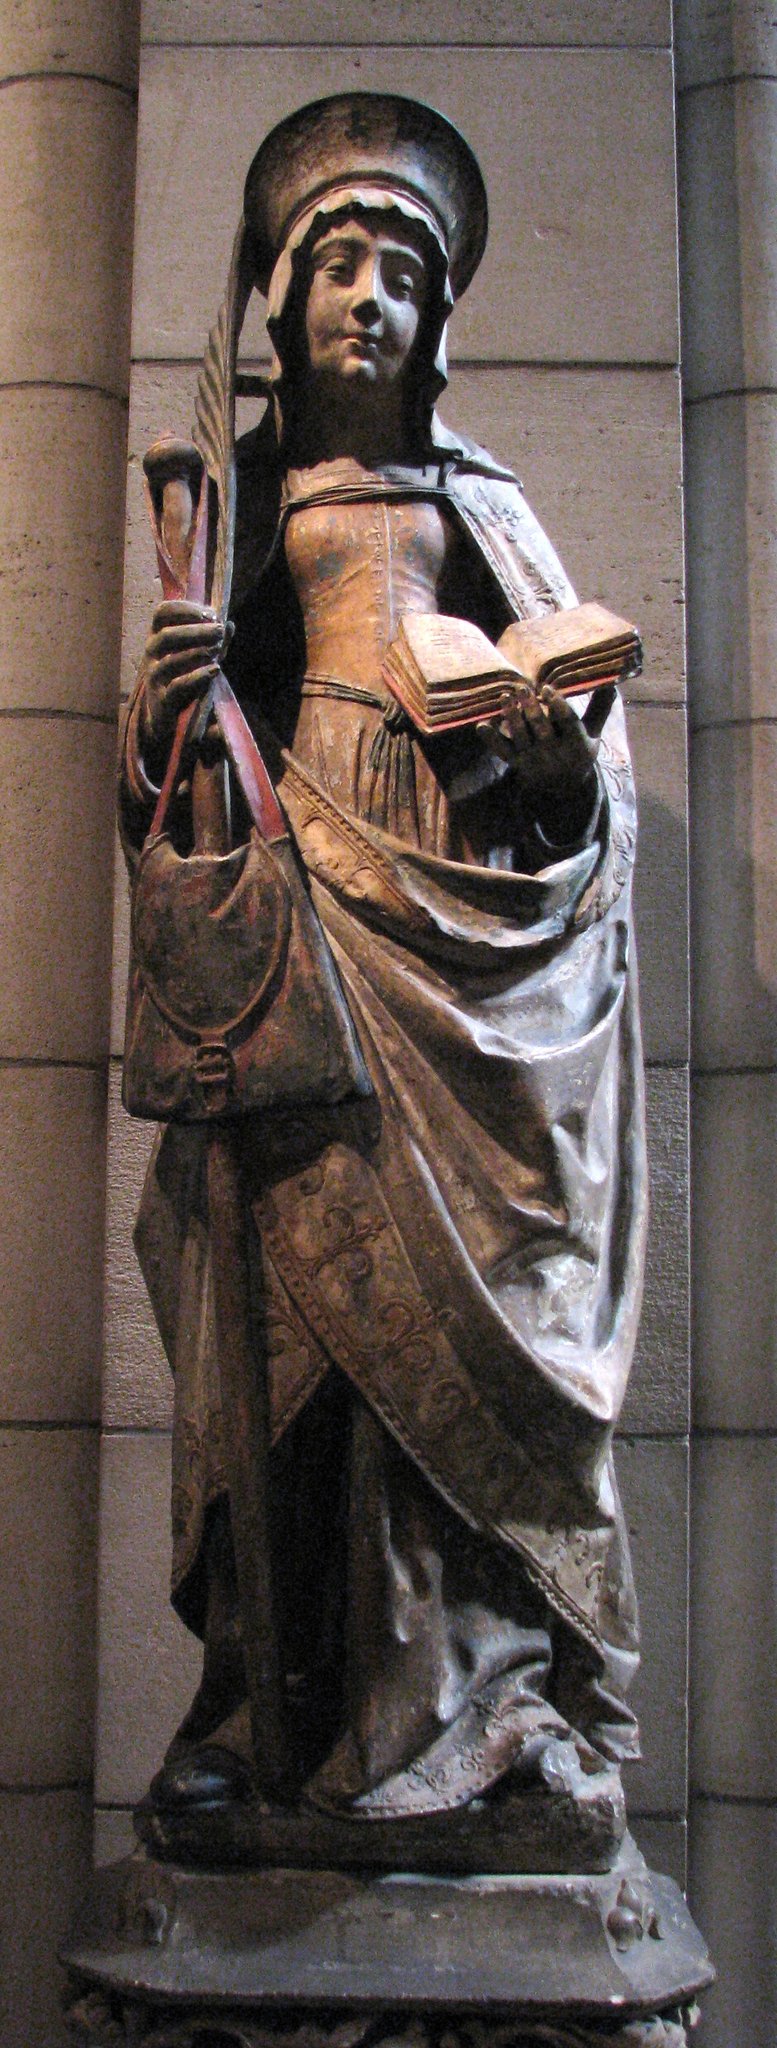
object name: sculpture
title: Saint Savina of Troyes or Saint Syra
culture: french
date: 1510-1520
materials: limestone, paint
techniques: gilding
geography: france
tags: women